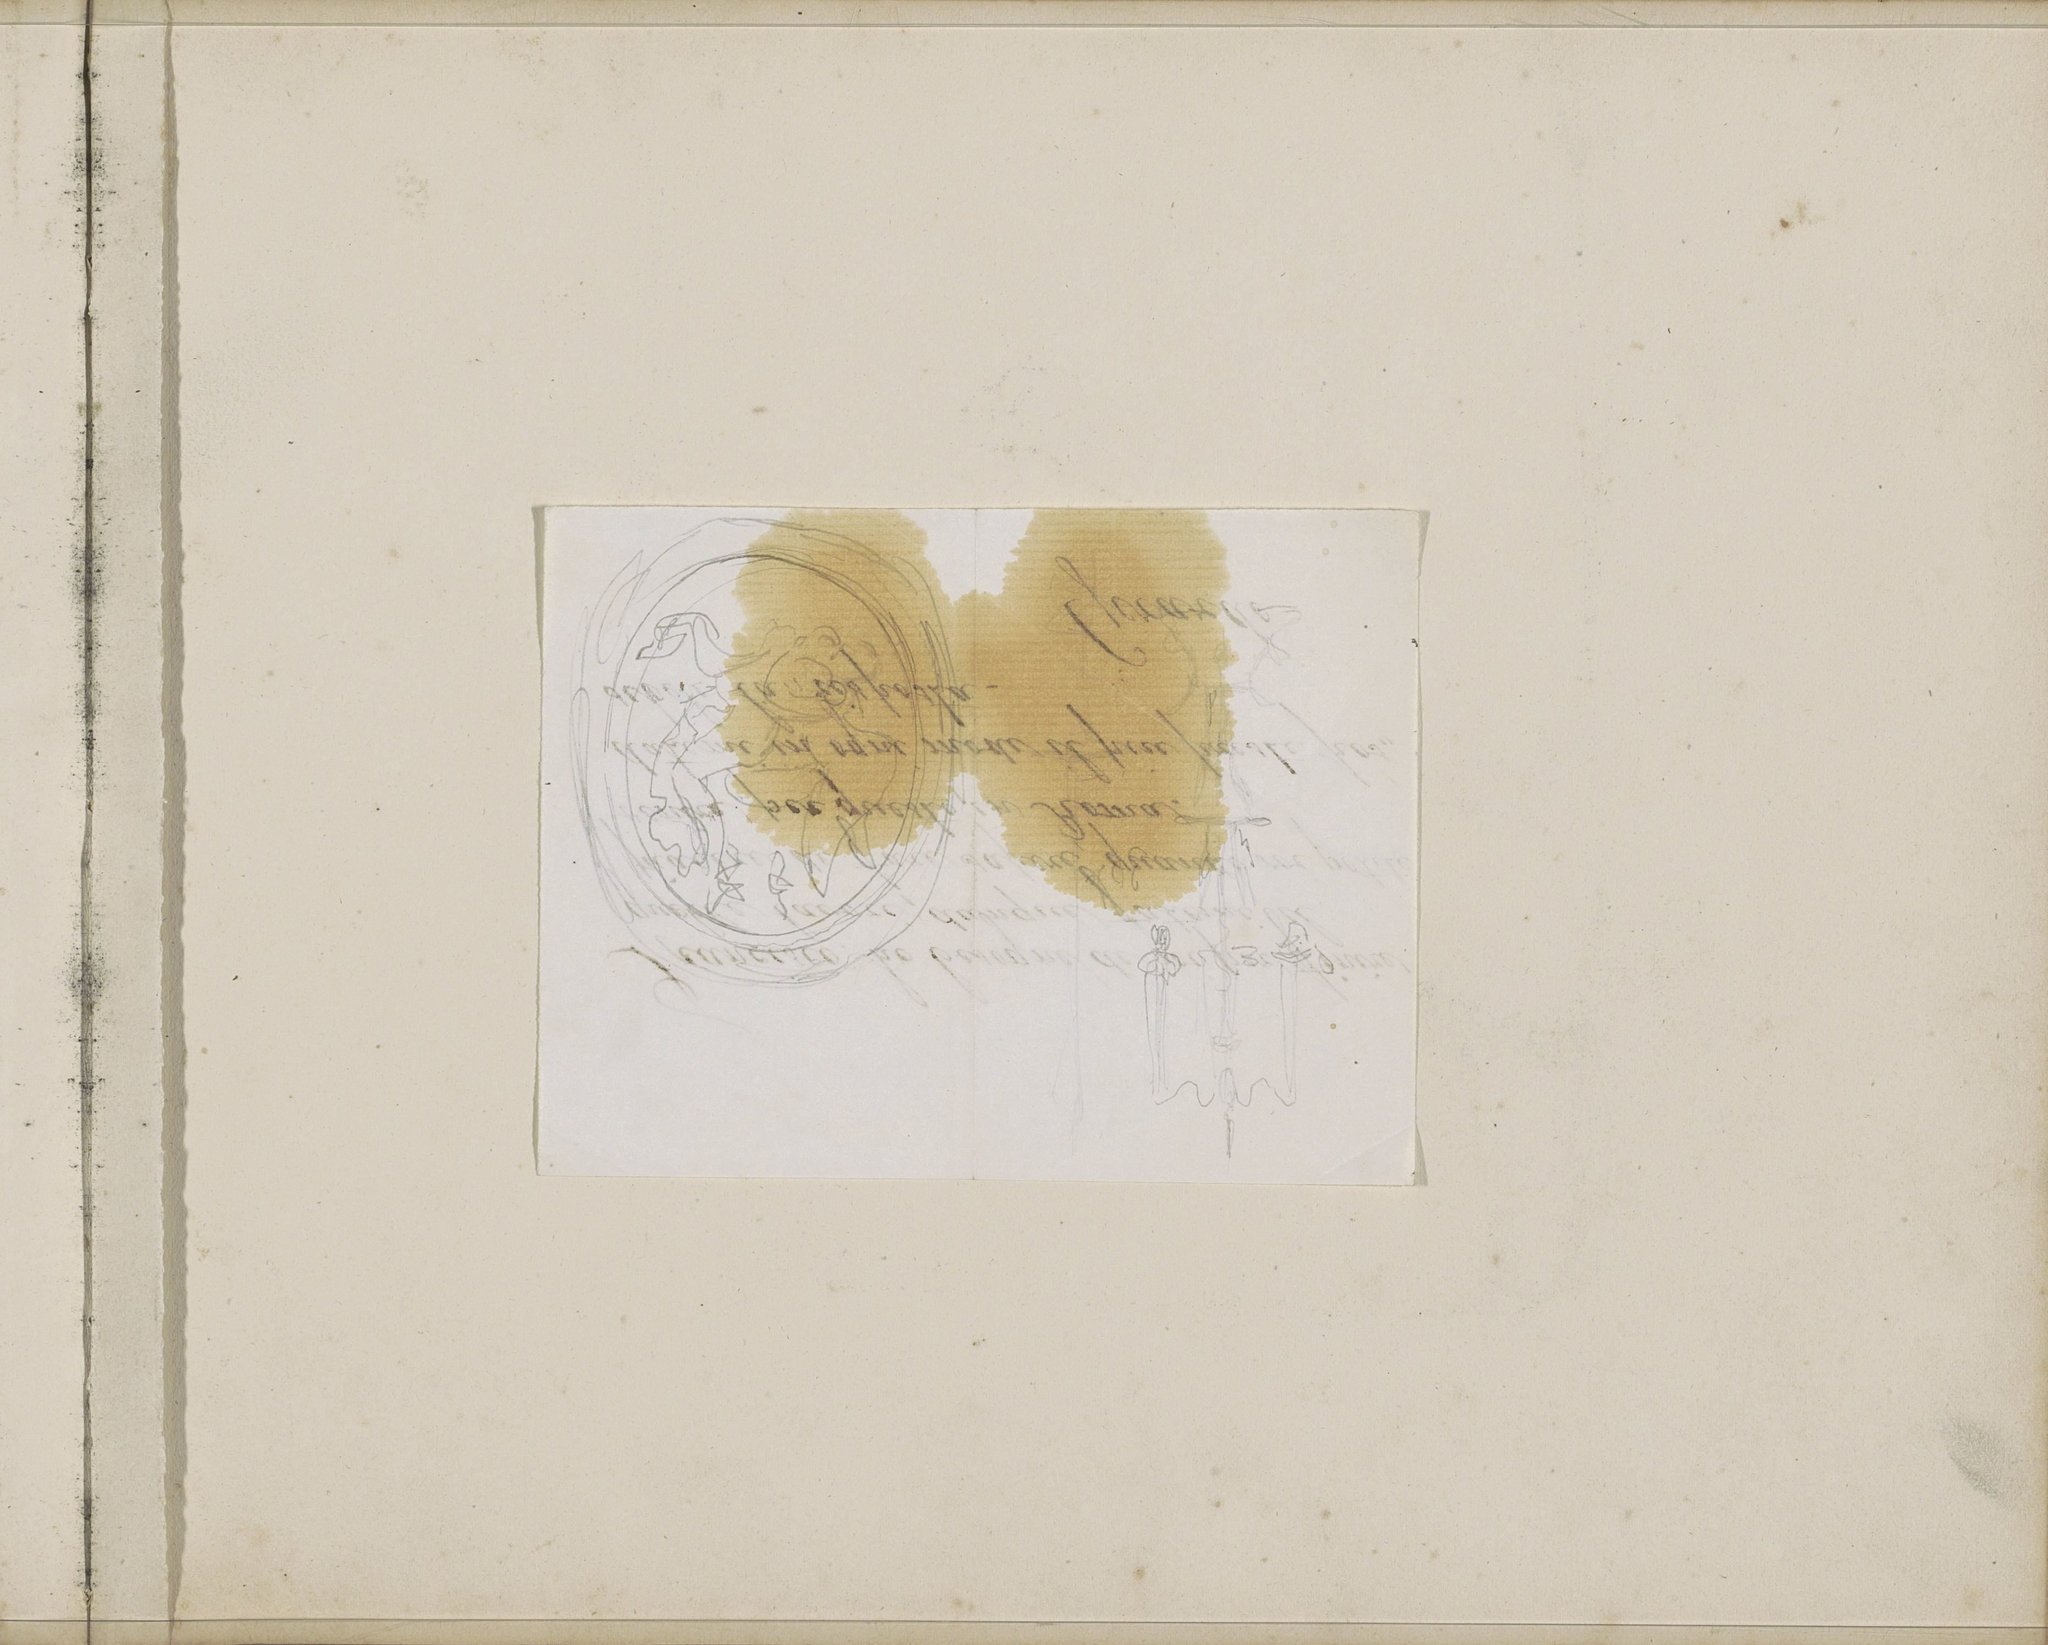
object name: sketchbook leaf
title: Engel in een medaillon en een vaandel op een standaard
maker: gerrit postma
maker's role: draughtsman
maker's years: 1819-1894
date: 1829-1894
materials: paper, pencil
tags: banner, standard (as symbol of the state, etc.), angels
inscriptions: annotation: ‘Francisco, ho besogne de voi per finire ... sebele la riposta./ Gerardo’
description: Los blad met tekening en annotatie tussen blad 28 en 29 van een schetsboek met 35 bladen.